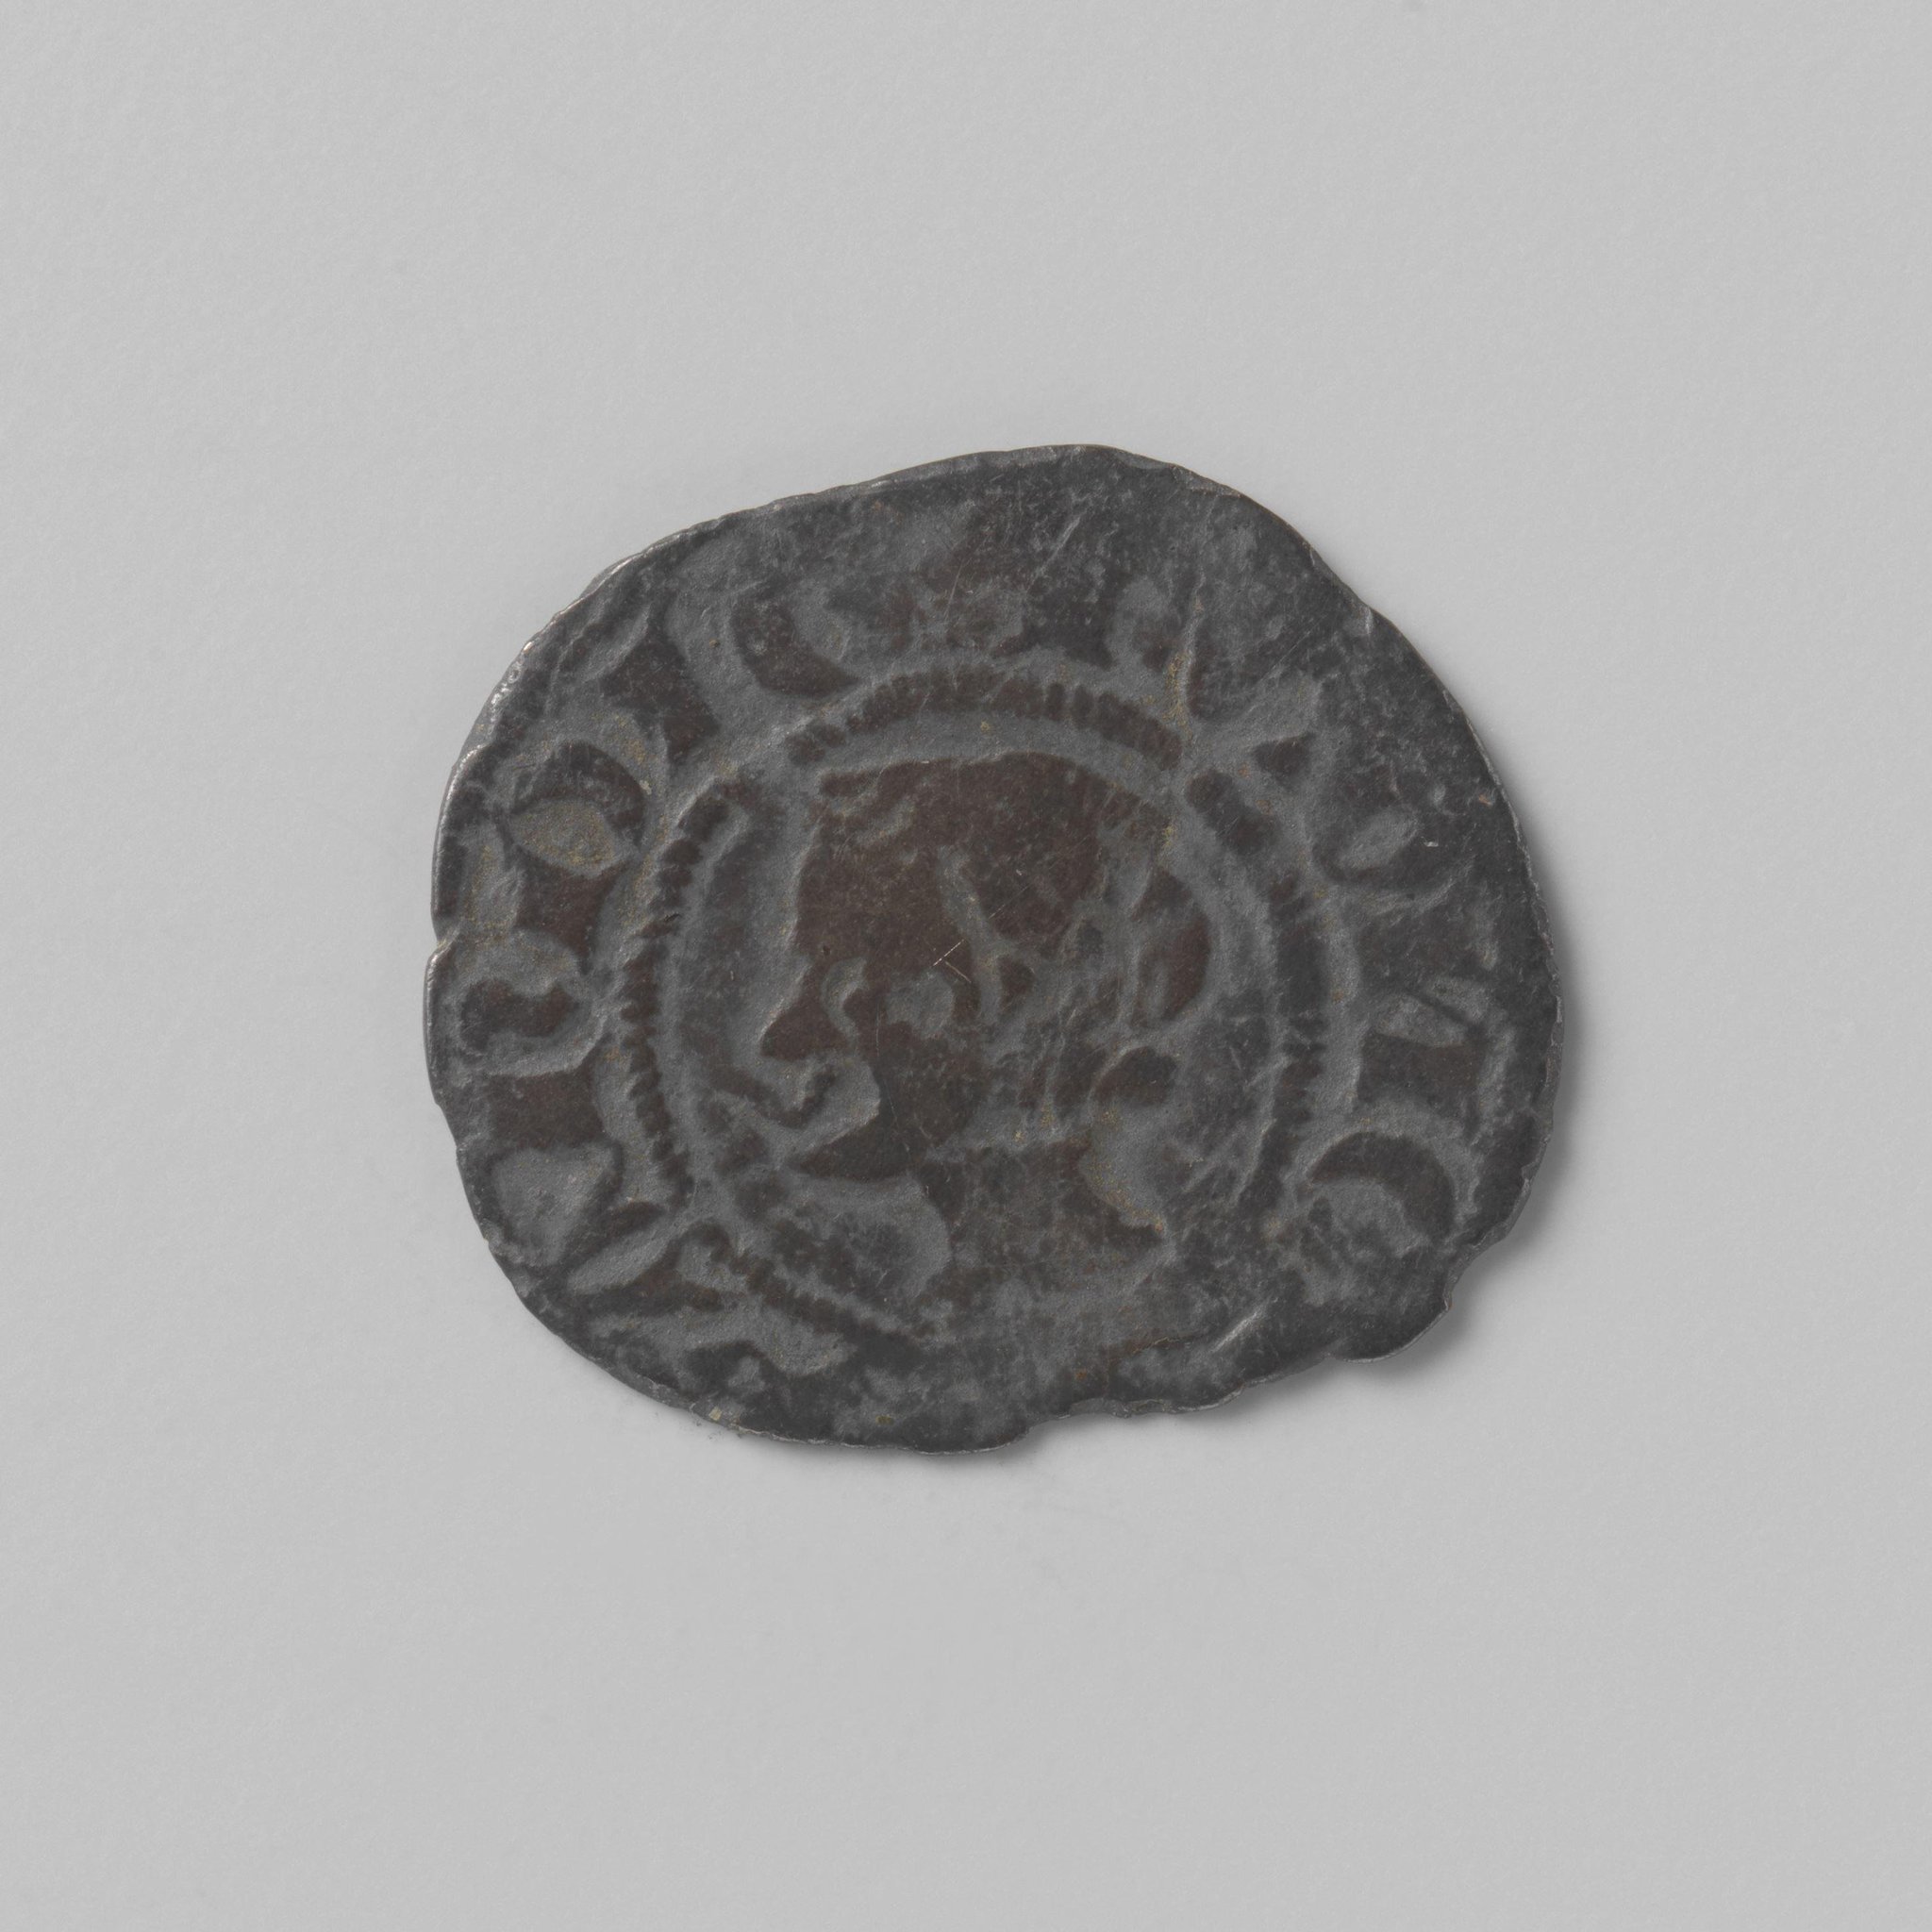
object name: penny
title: Hollandse penning van Floris V, 1256-1296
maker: floris v (graaf van holland en zeeland)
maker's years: 1254-1296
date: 1293-1296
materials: silver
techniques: striking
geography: dordrecht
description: Zilveren munt. Voorzijde: hoofd zonder gravenmuts naar links. Keerzijde: lang glad kruis, in hoeken roosjes.